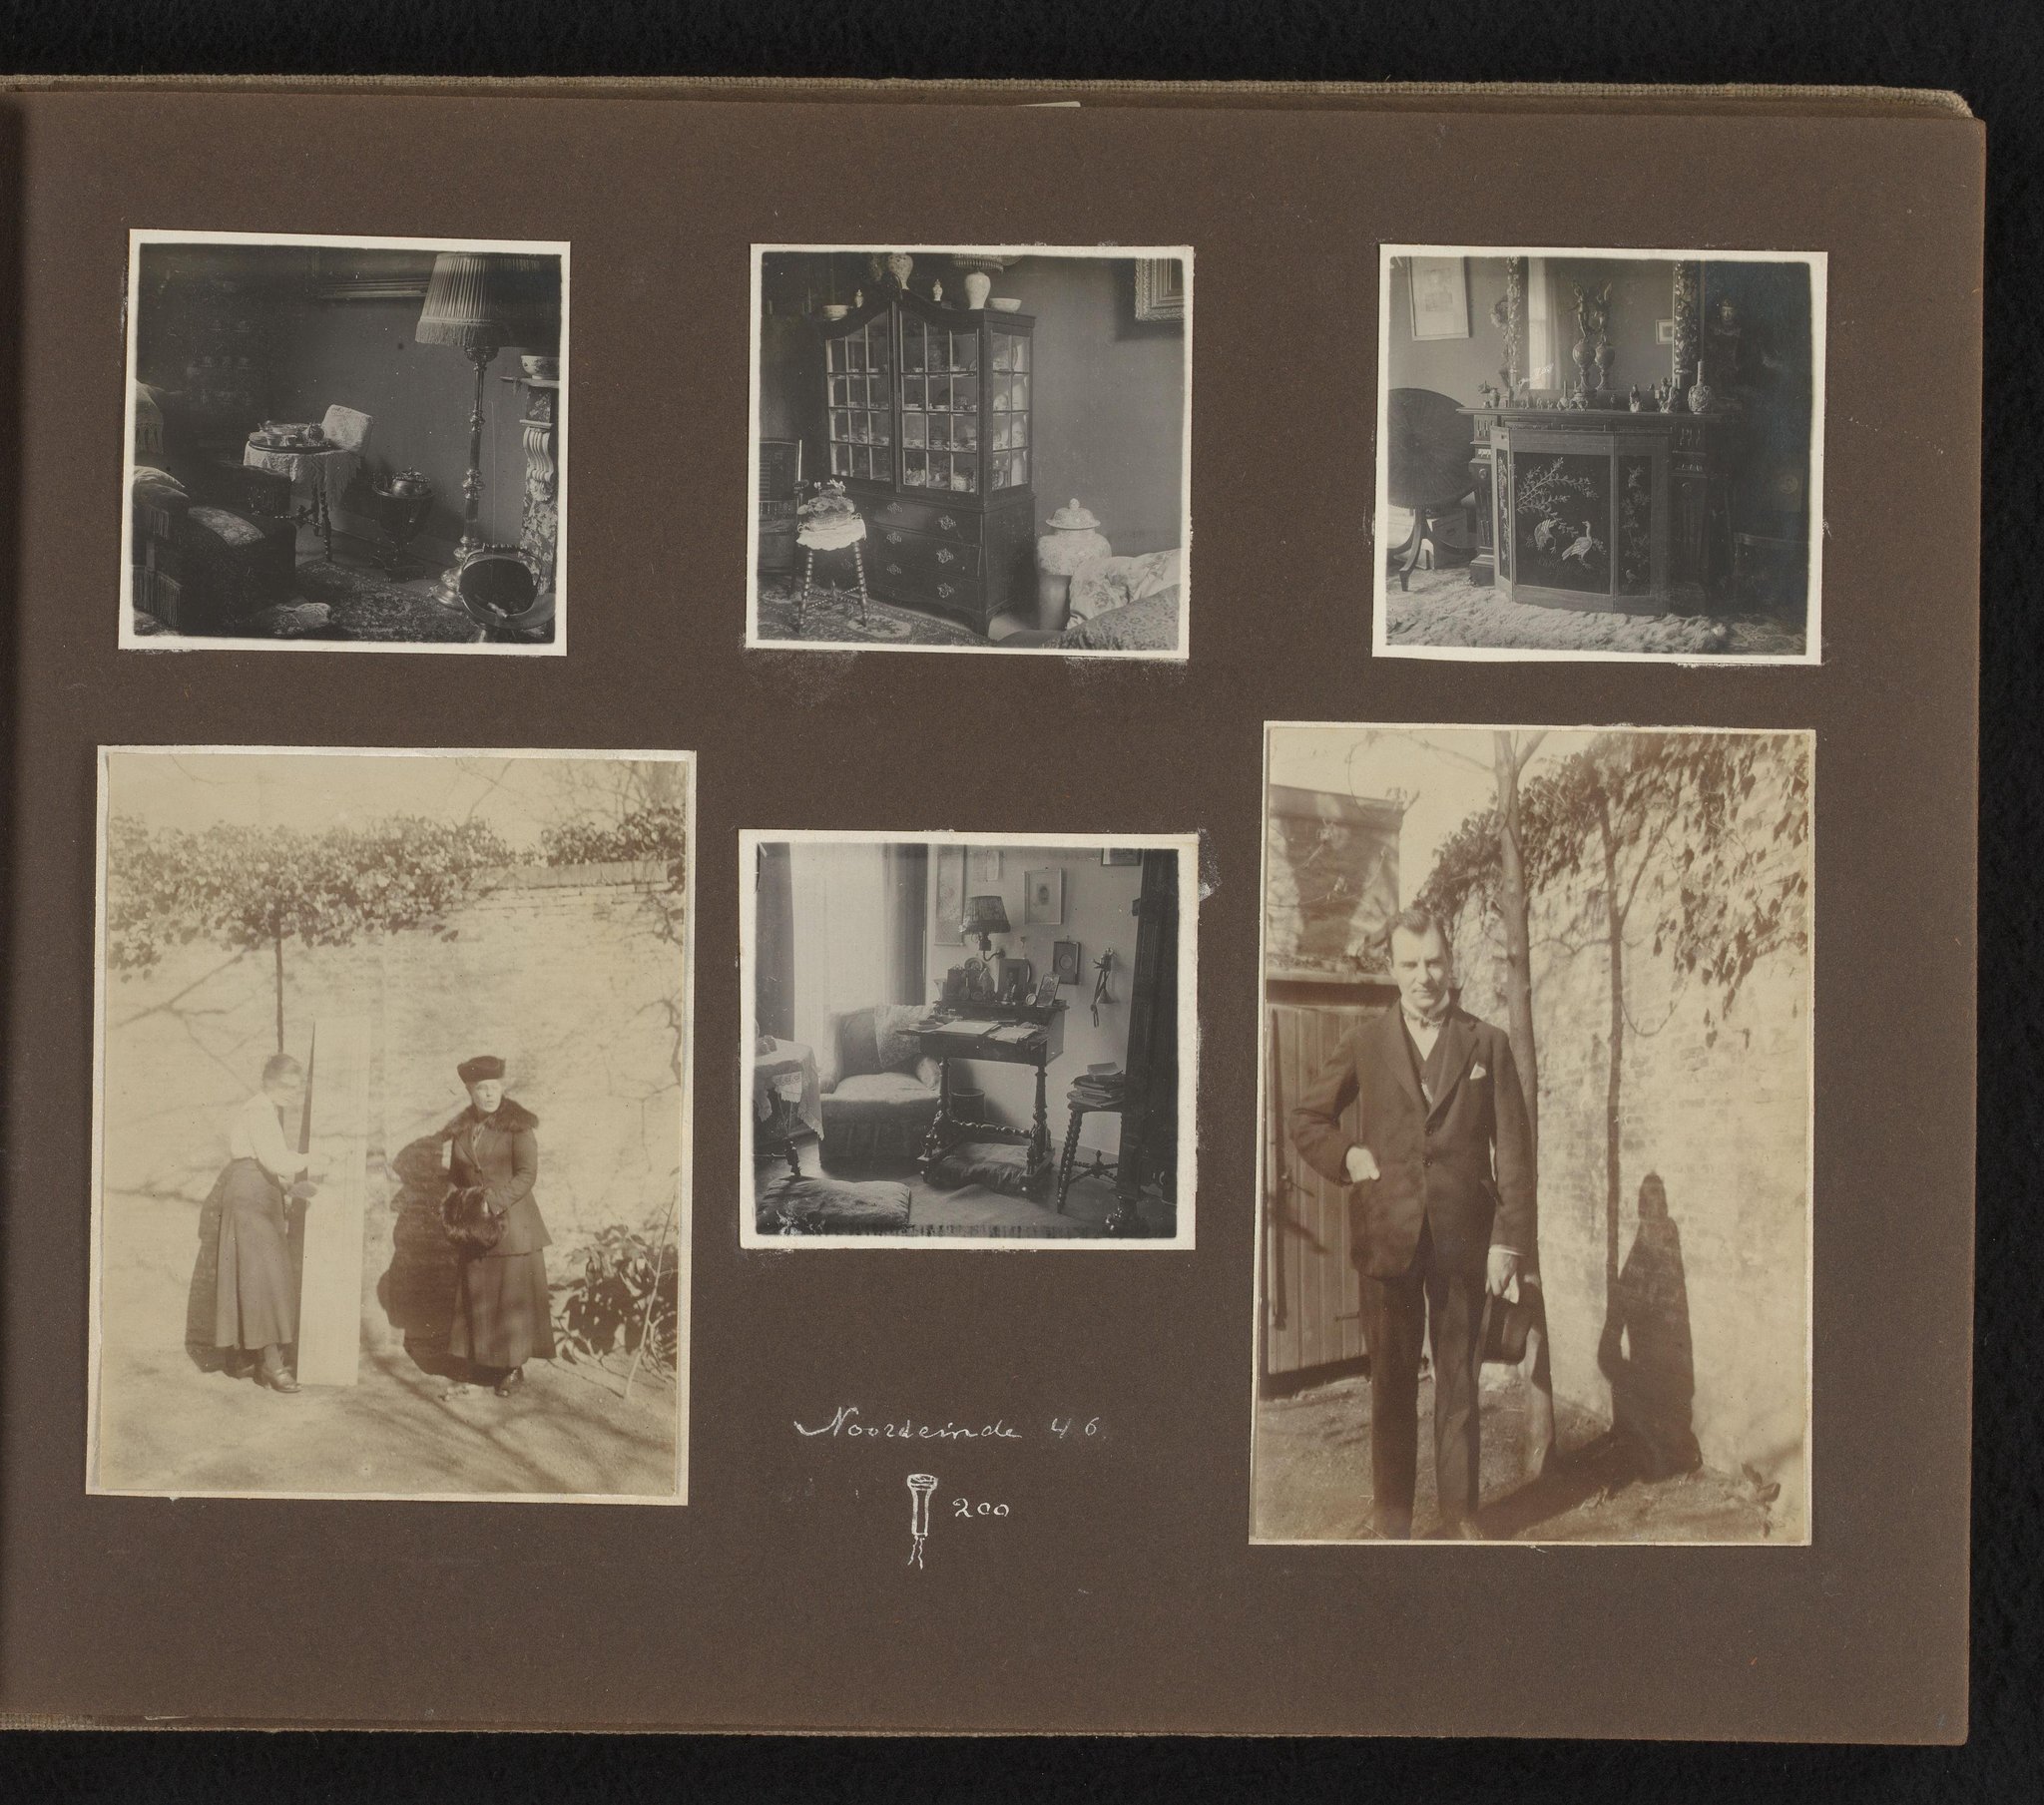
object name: photograph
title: Interieur en de tuin, met Johanna (Hans) de Jong, Frederik (Frits) Stokhuyzen en vermoedelijk Elisabeth de Jong, van het Noordeinde 46 te Leiden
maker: willem de jong (fotograaf)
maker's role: arts, fotograaf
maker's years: 1864-1918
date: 1915-1920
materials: paper, cardboard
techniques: gelatin silver print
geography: leiden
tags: haarlem, elisabeth de jong-van tonderen, leiden, johanna petronella lambertina stokhuyzen-de jong (hans), frederik stokhuyzen (frits), garden, historical persons, interior of the house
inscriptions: address: ‘Noordeinde 46’, inscription: ‘200’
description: Deze foto's maken deel uit van een album.